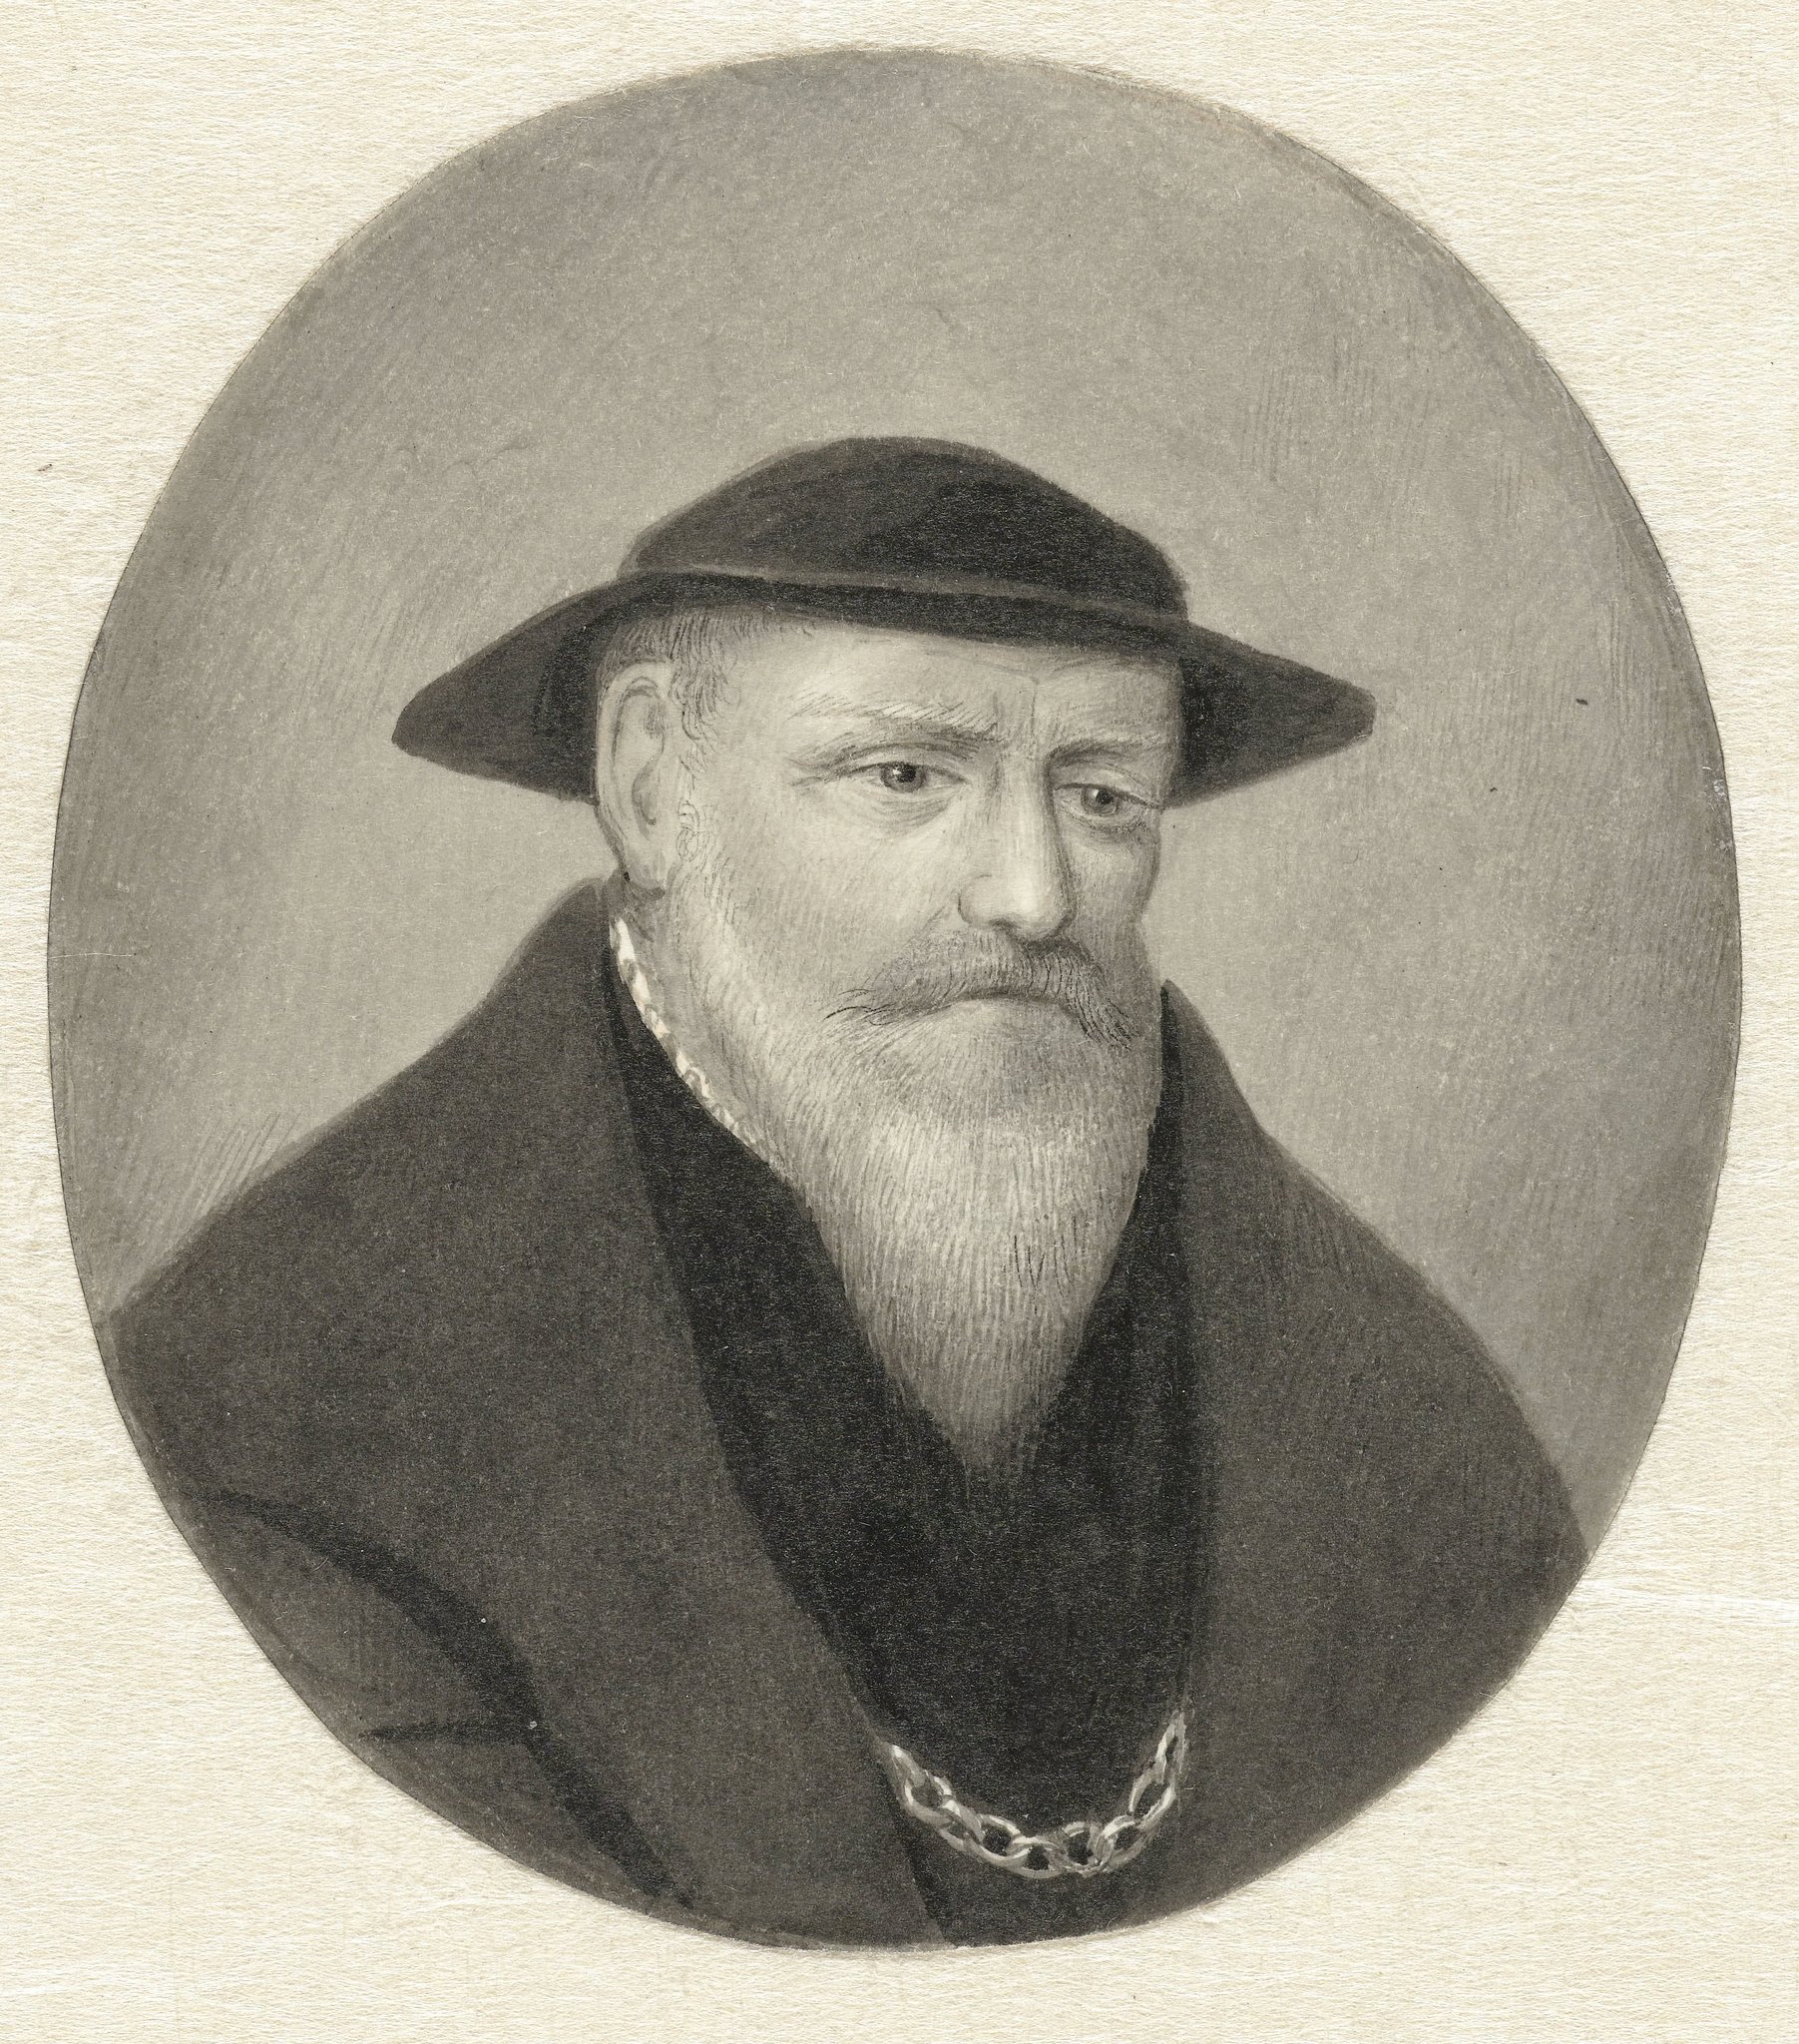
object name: drawing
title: Mansportret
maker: Anonymous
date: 1700-1800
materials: ink, paper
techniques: brush, pen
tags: anonymous historical person portrayed alone